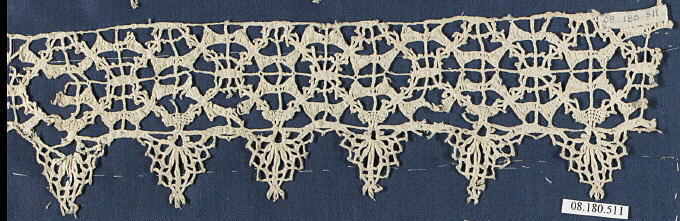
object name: fragment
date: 1501-1600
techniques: lace